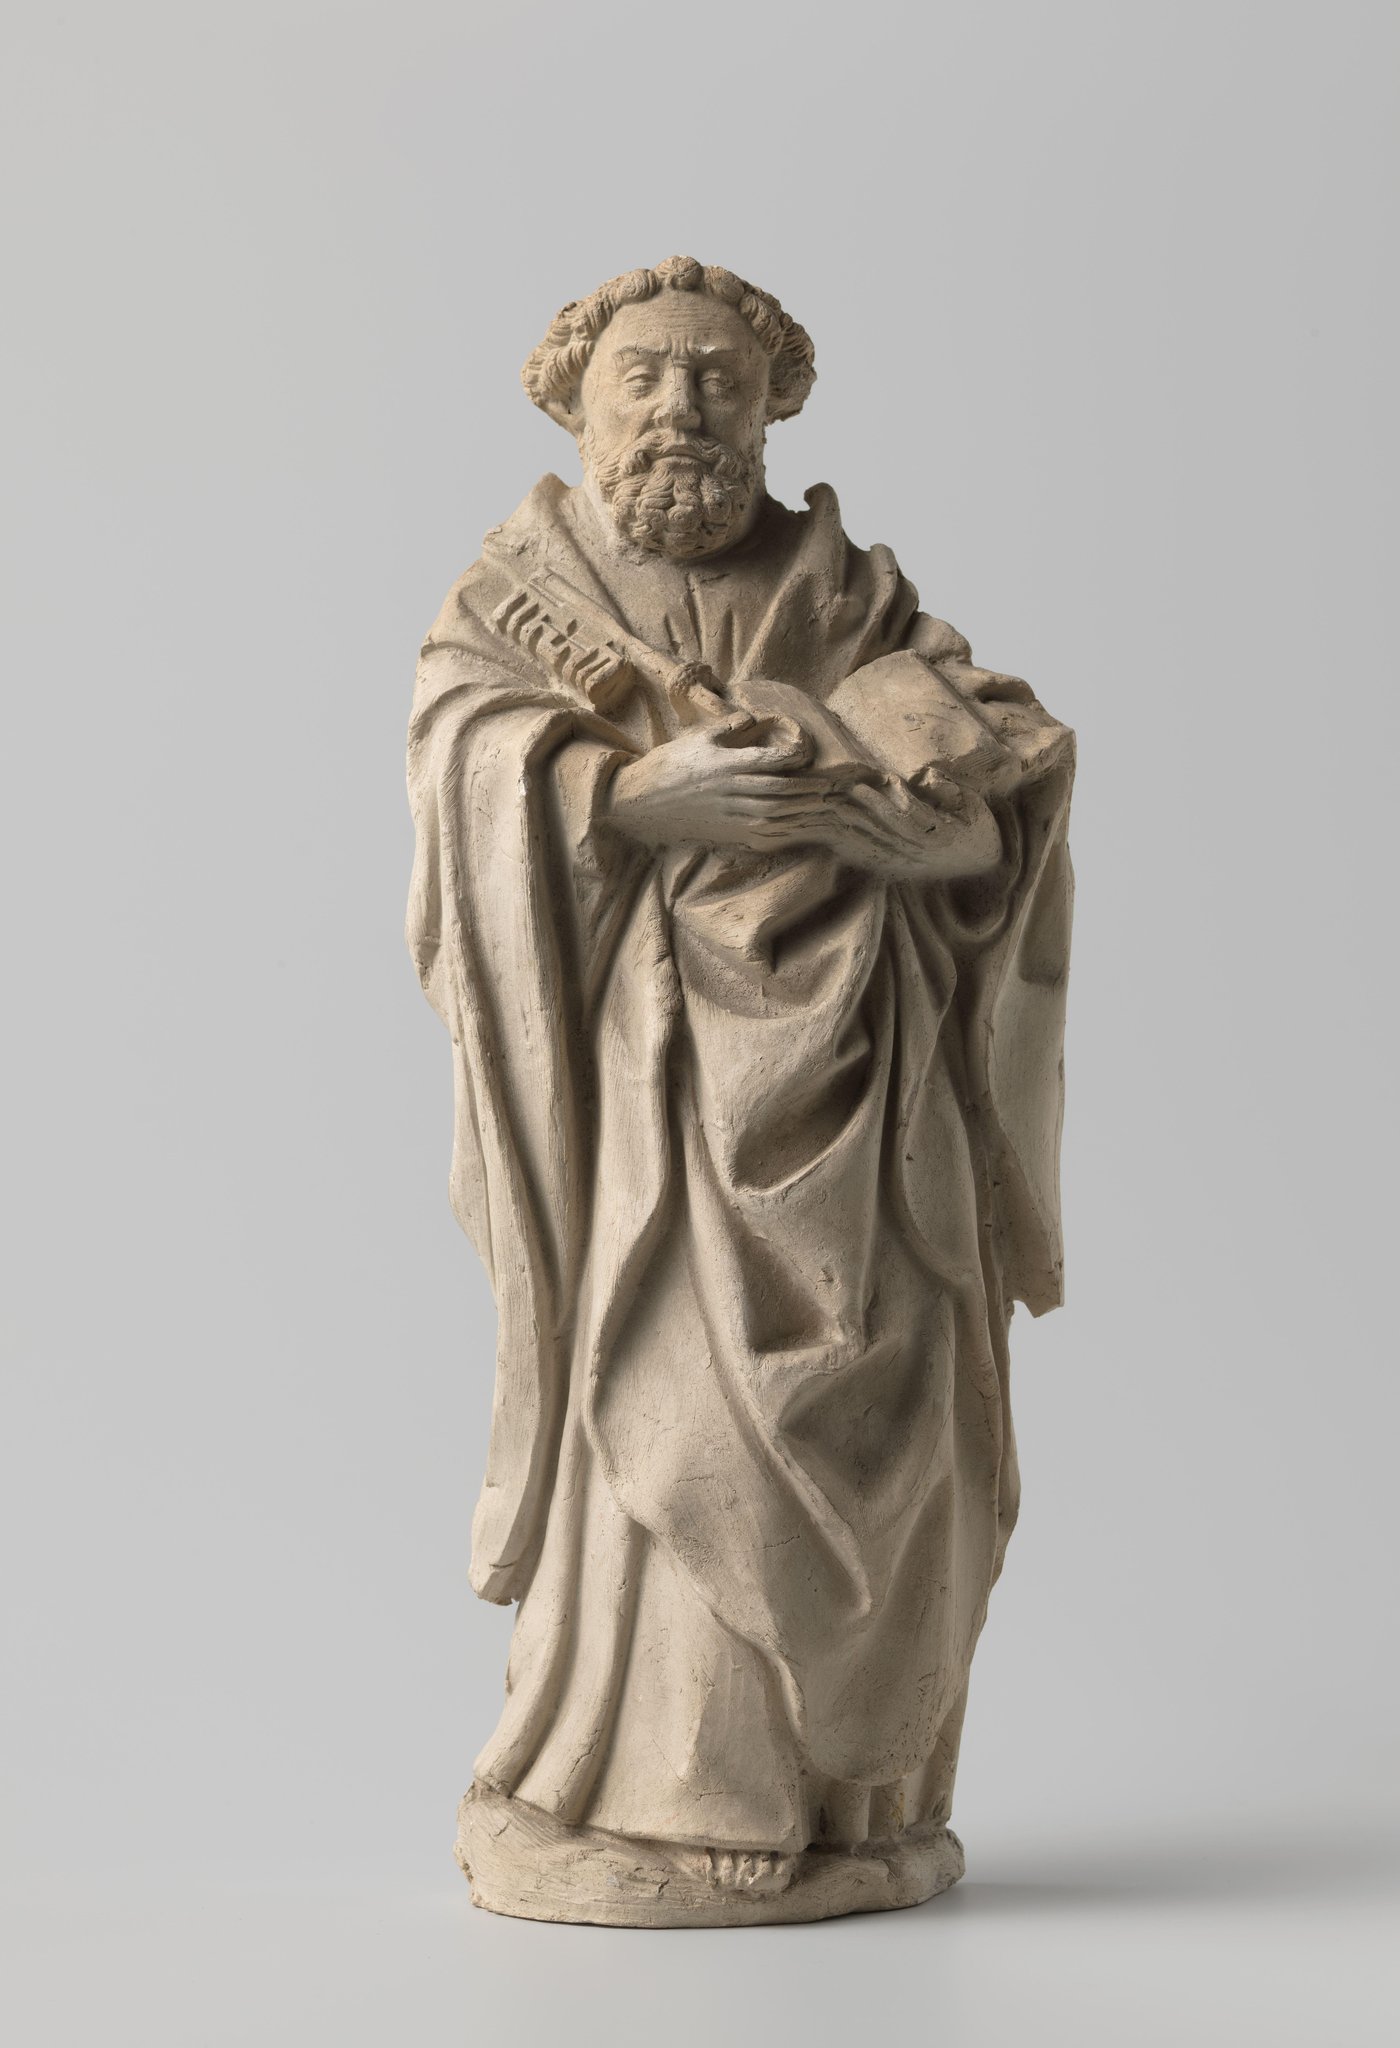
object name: figure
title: Beeld van St. Petrus met boek en sleutel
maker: Anonymous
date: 1500-1550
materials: gypsum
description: Beeld van St. Petrus met boek en sleutel. Afgietsel in gips.